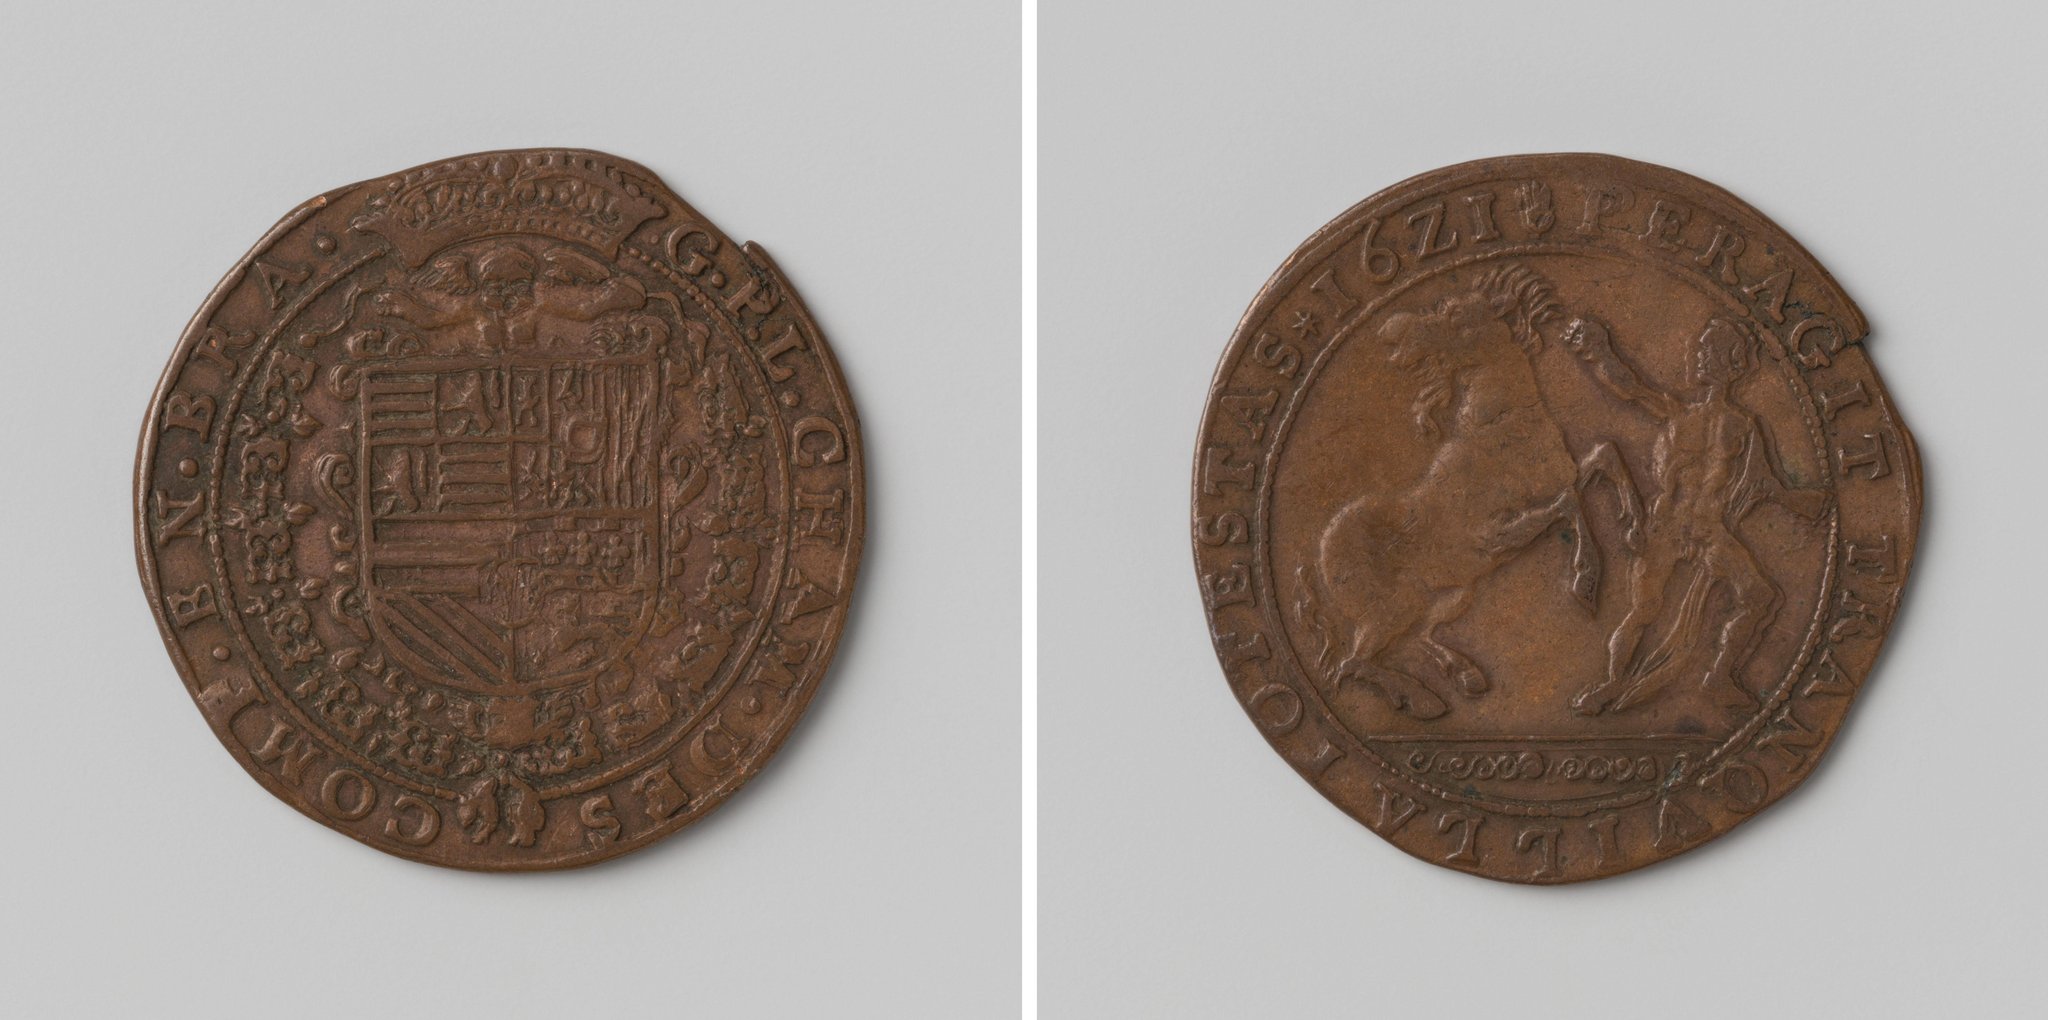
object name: jeton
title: Albrecht en Isabella van Oostenrijk, rekenpenning geslagen op last van de rekenkamer van Brabant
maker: Anonymous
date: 1621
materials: copper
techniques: striking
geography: antwerp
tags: infante van spanje isabella clara eugenia, brussels, albrecht aartshertog van oostenrijk, brabant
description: Koperen penning. Voorzijde: gekroond wapenschild, omhangen met de door een engeltje vastgehouden orde van het Gulden Vlies binnen omschrift. Keerzijde: man probeert steigerend paard te temmen binnen omschrift; afsnede: siermotief